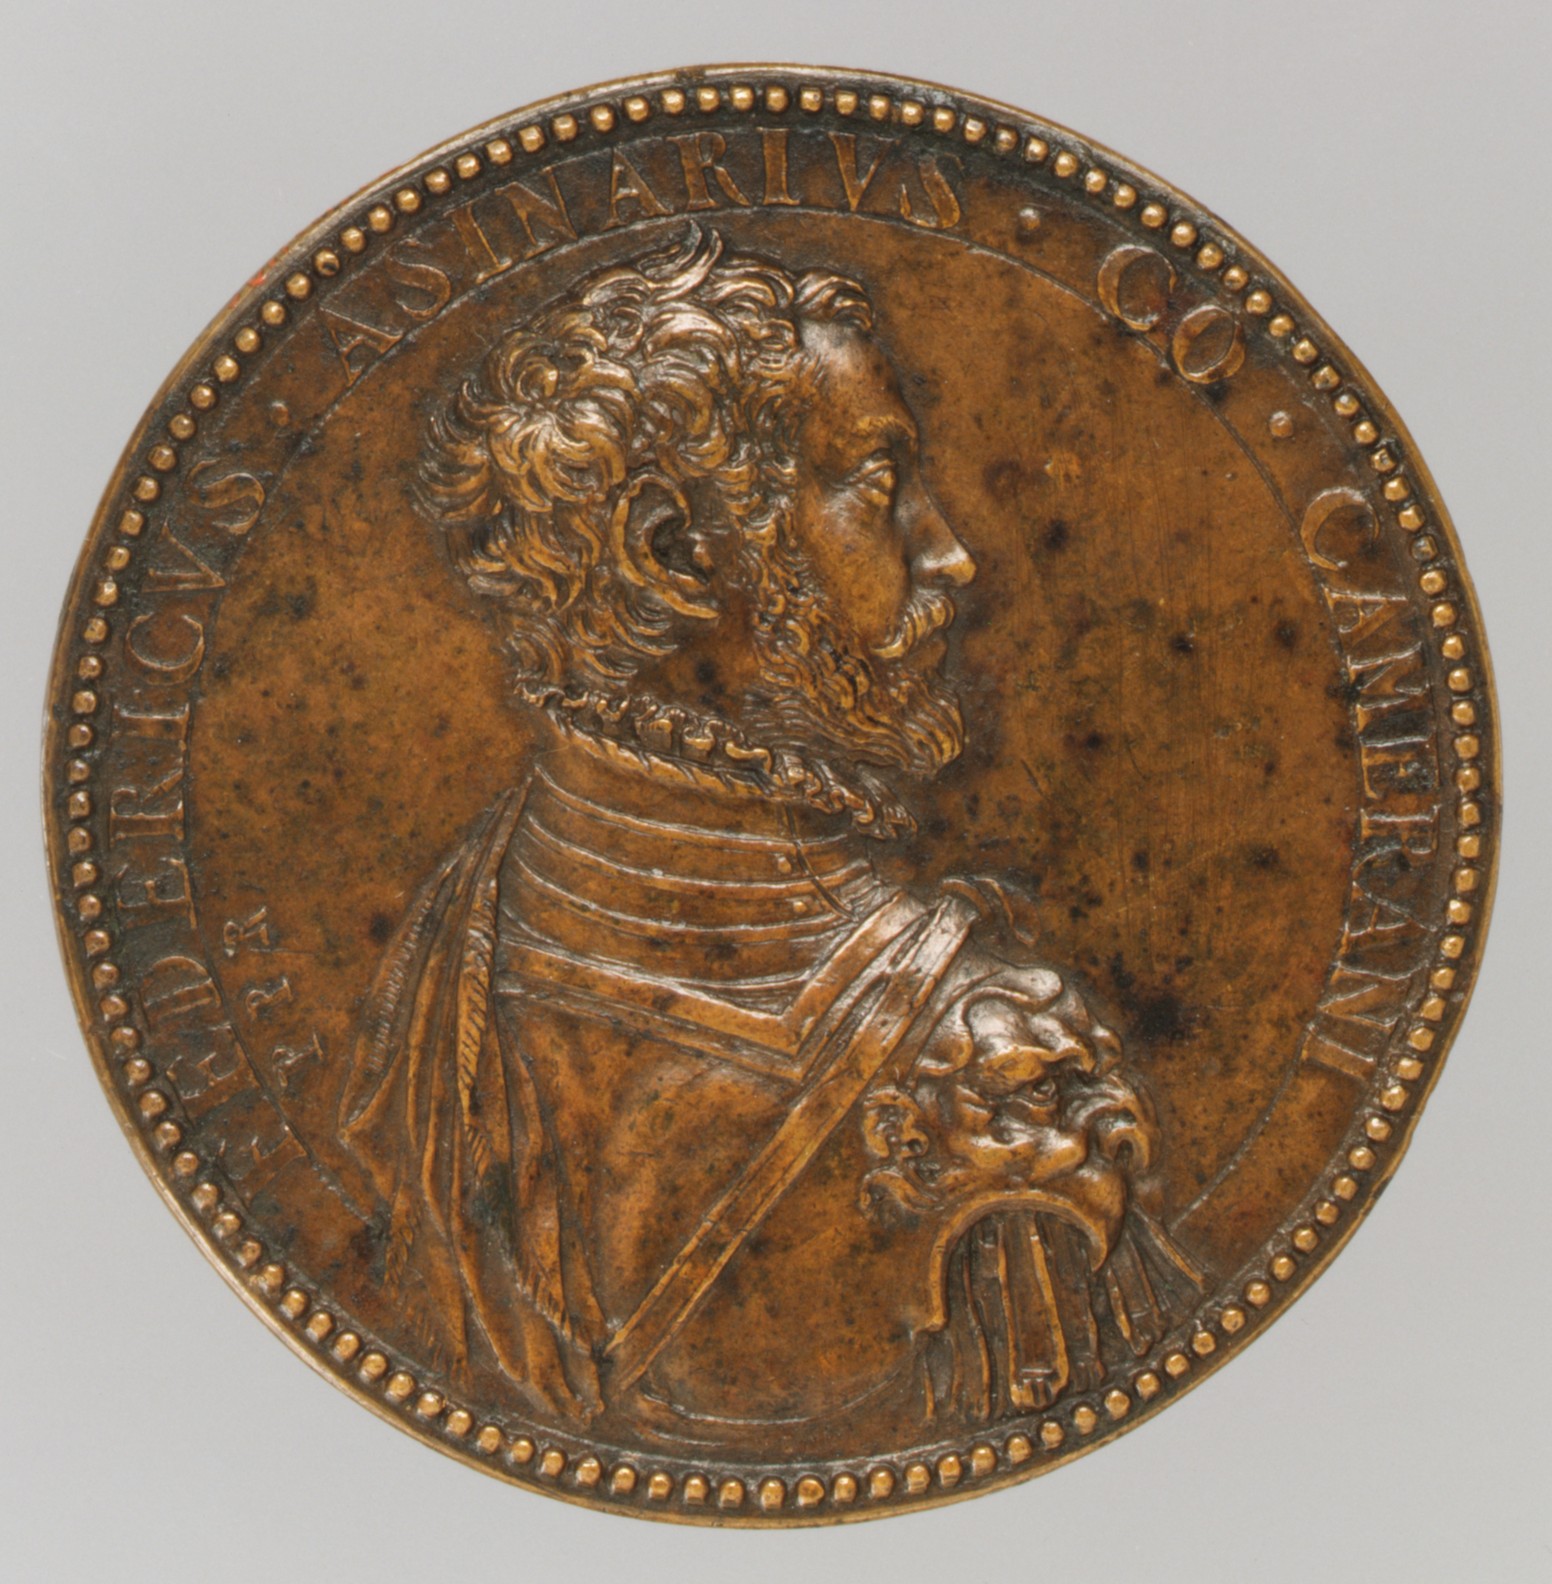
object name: medal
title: Federigo Asinari, Count of Camerano (1527–1575)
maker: pietro paolo galeotti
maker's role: artist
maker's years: 1500-1600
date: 1550-1575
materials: bronze, patina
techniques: casting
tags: men,profiles